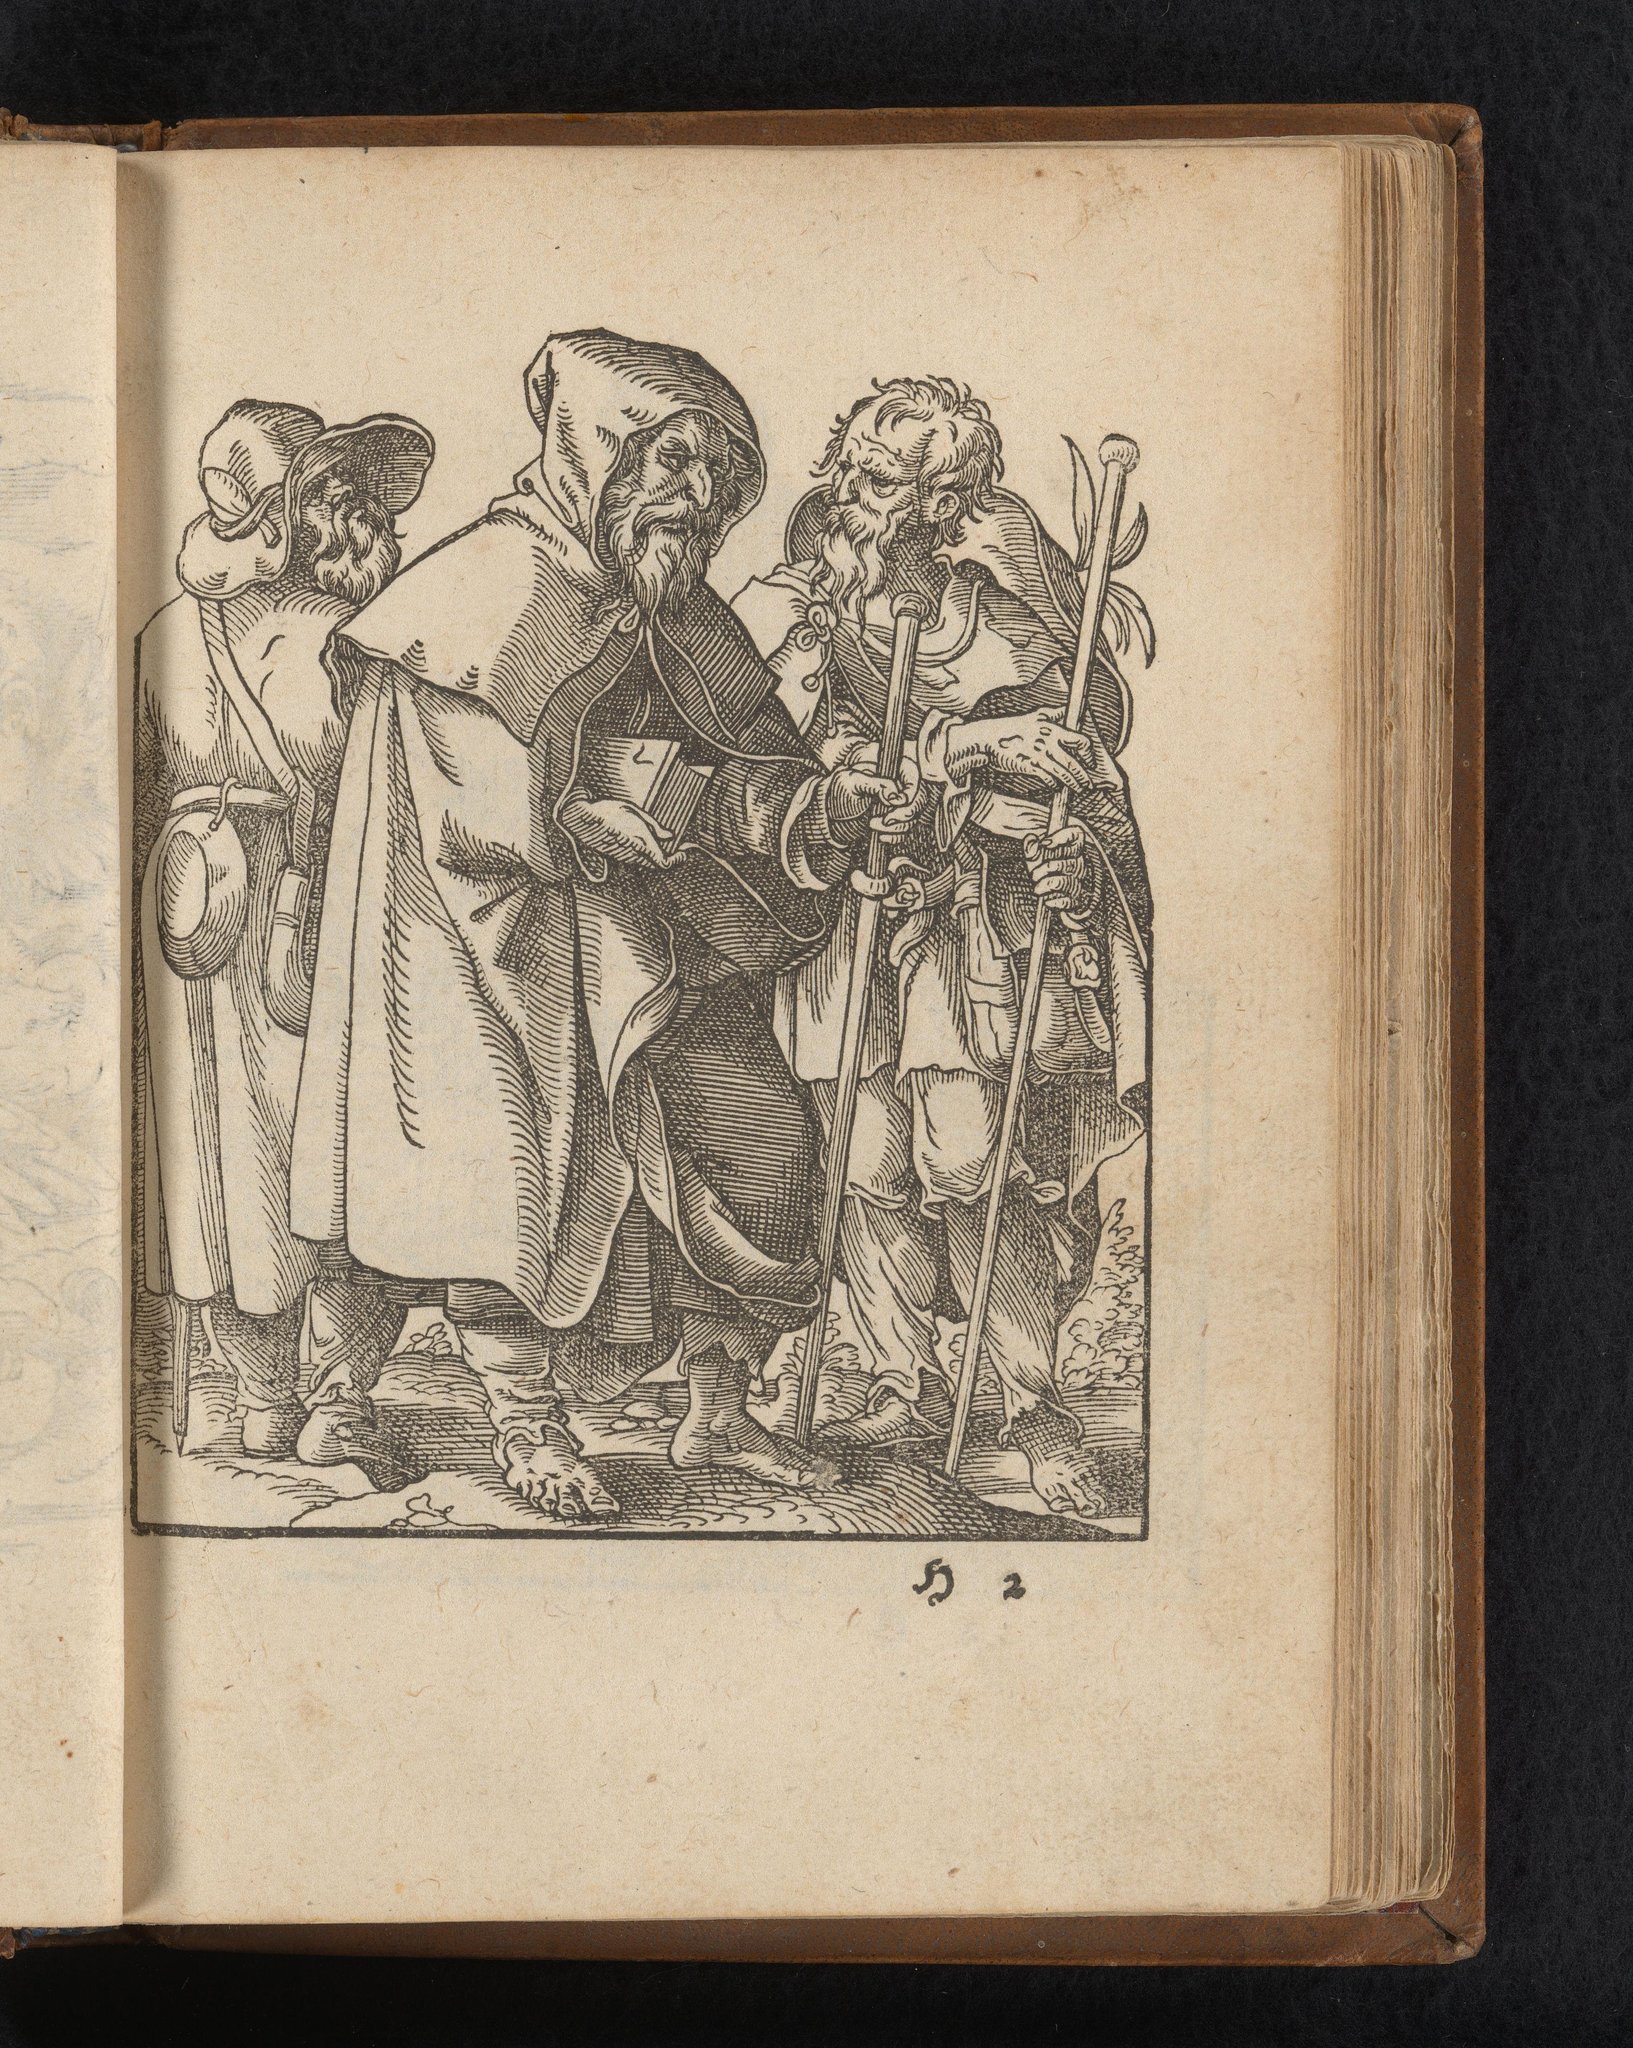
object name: print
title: Drie pelgrims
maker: Anonymous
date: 1578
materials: paper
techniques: woodcut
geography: nuremberg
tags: pilgrim(s)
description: Drie pelgrims op bedevaart. Onderdeel van het modelboek Enchiridion artis pingendi, fingendi & sculpendi met 108 figuren bedoeld voor beginnende schilders, beeldhouwers en prentmakers.